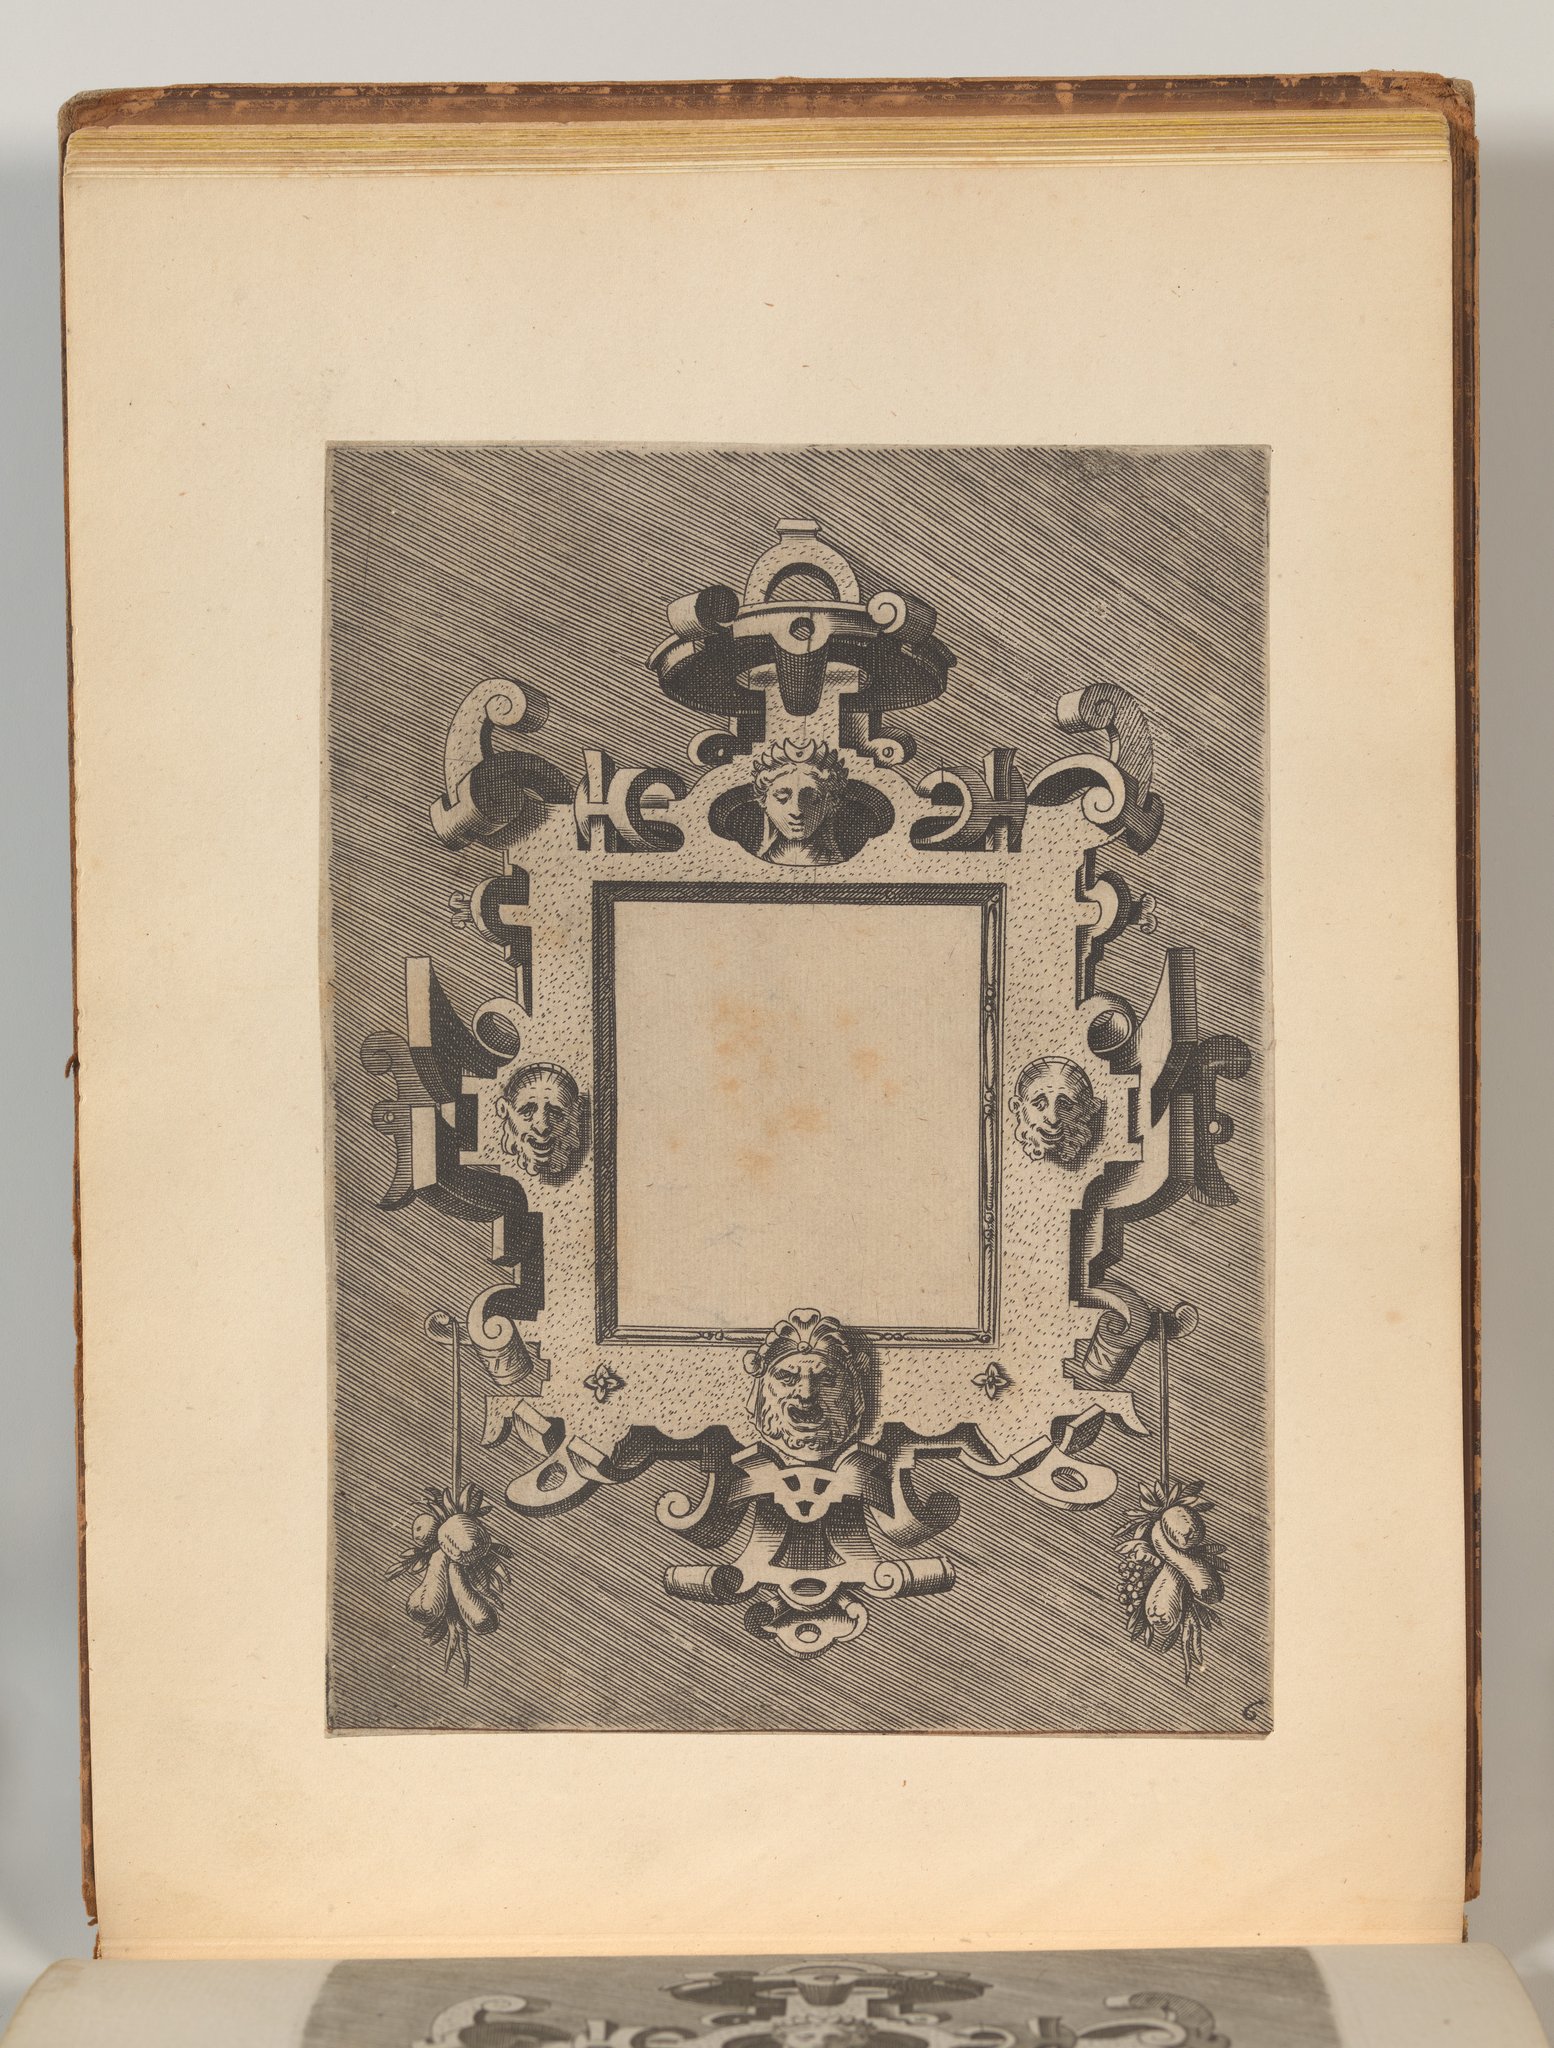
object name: album print ornament architecture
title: Targhe ed altri ornati di varie e capricciose invenzioni (Cartouches and other ornaments of various and capricious invention, page 28)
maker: hans vredeman de vries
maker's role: artist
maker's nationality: netherlandish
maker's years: 1527-1606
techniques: engraving, etching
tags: cartouches,faces